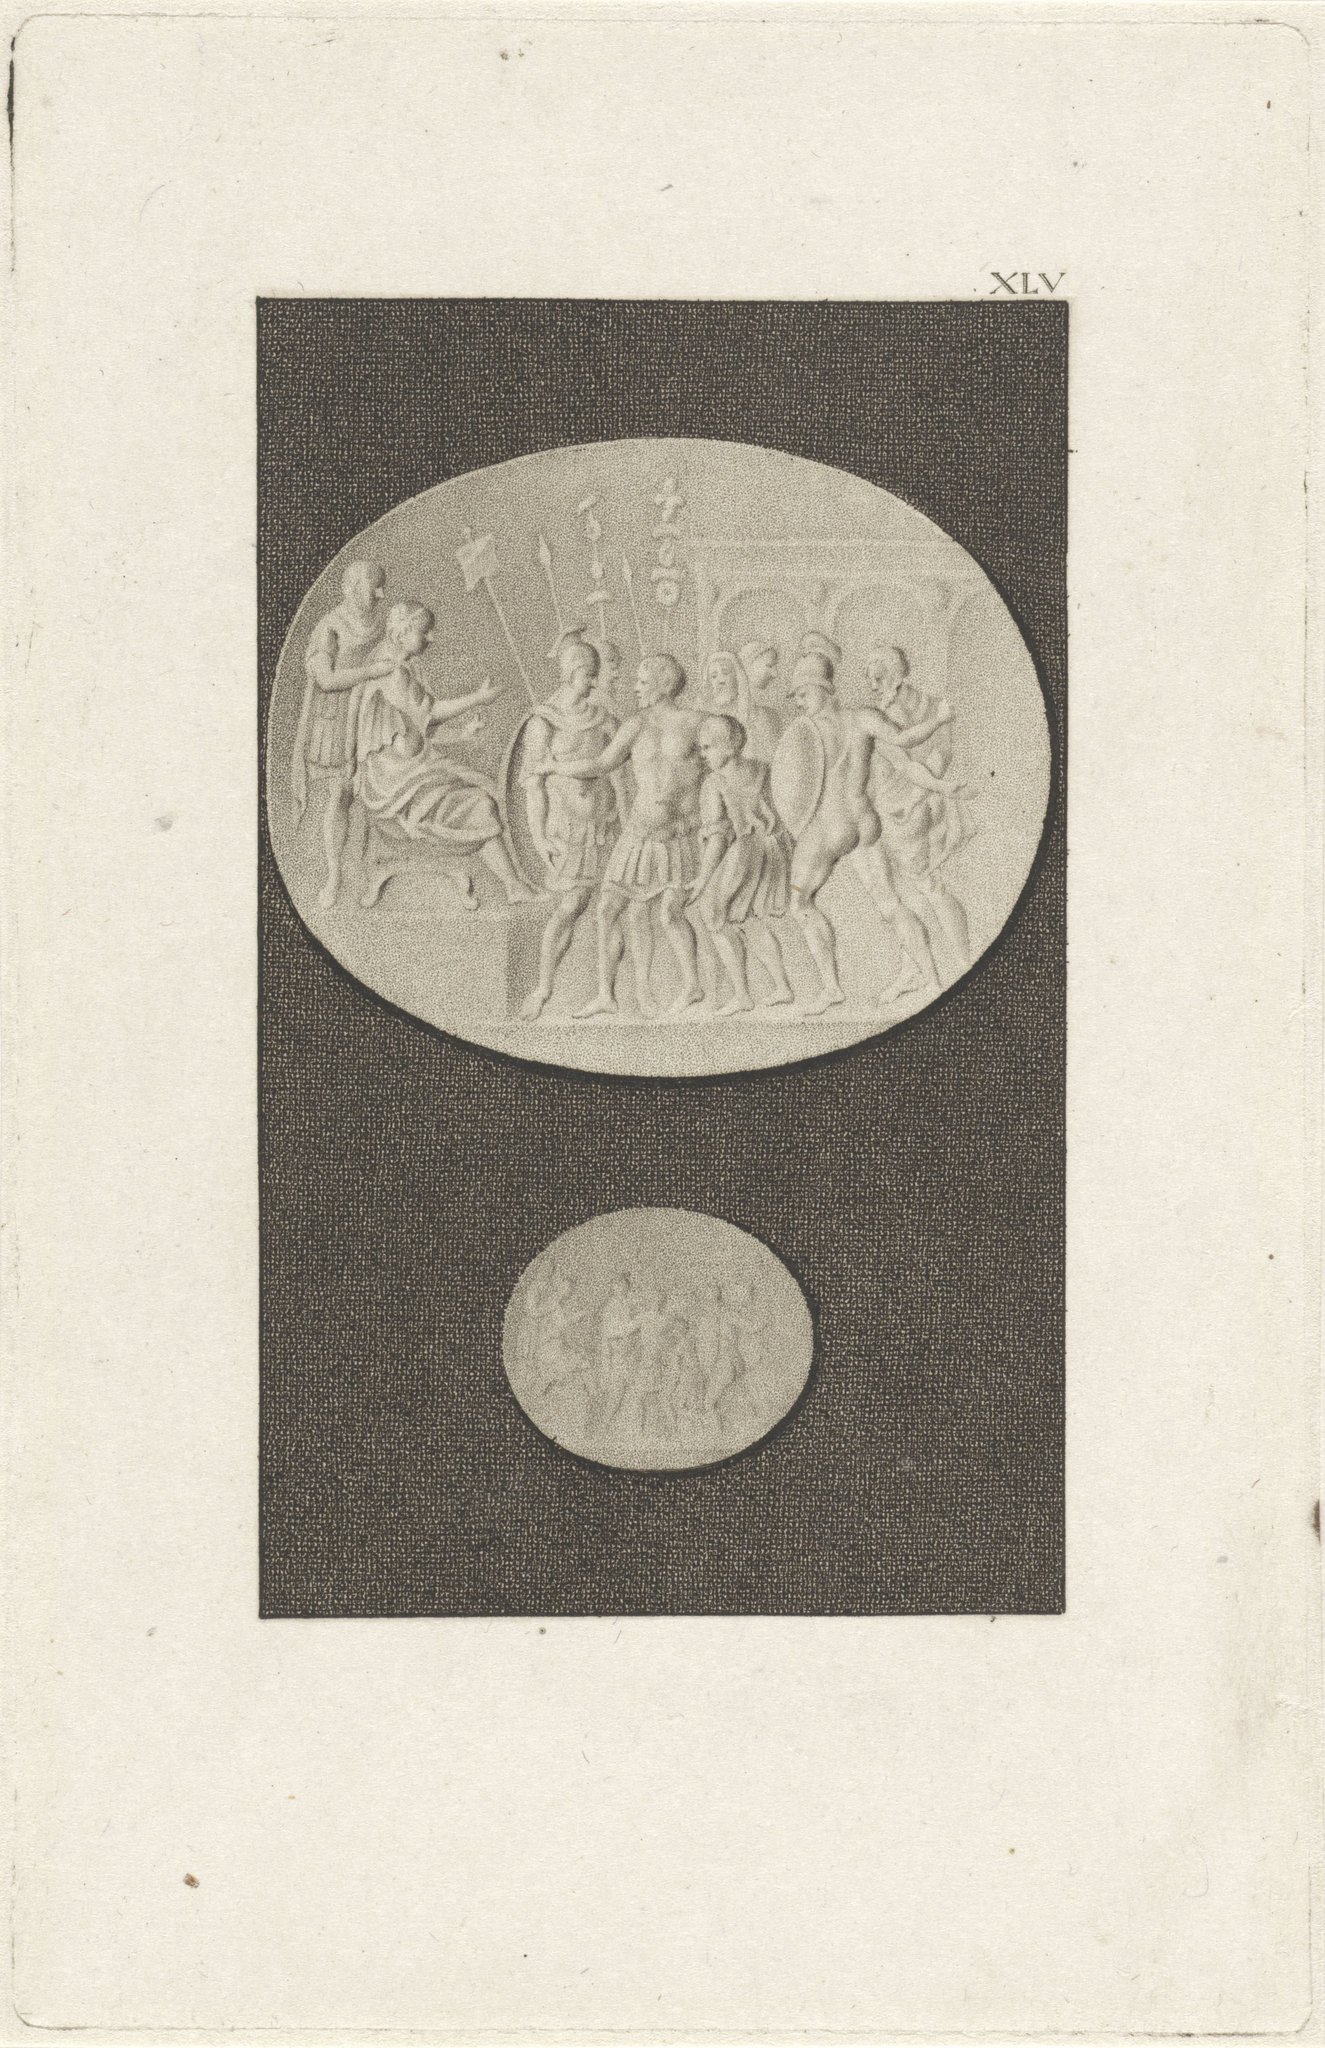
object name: book illustration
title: Gem met de gevangenname van Jugurtha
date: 1798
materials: paper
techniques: etching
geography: amsterdam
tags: male persons from classical history (sylla)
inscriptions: collector's mark: Lugt 2228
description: Voorafgaand aan het overleg met Sulla, waarbij Jugurtha ongewapend en slechts vergezeld van een paar mannen verschijnt, slaan diens soldaten hem in de boeien.